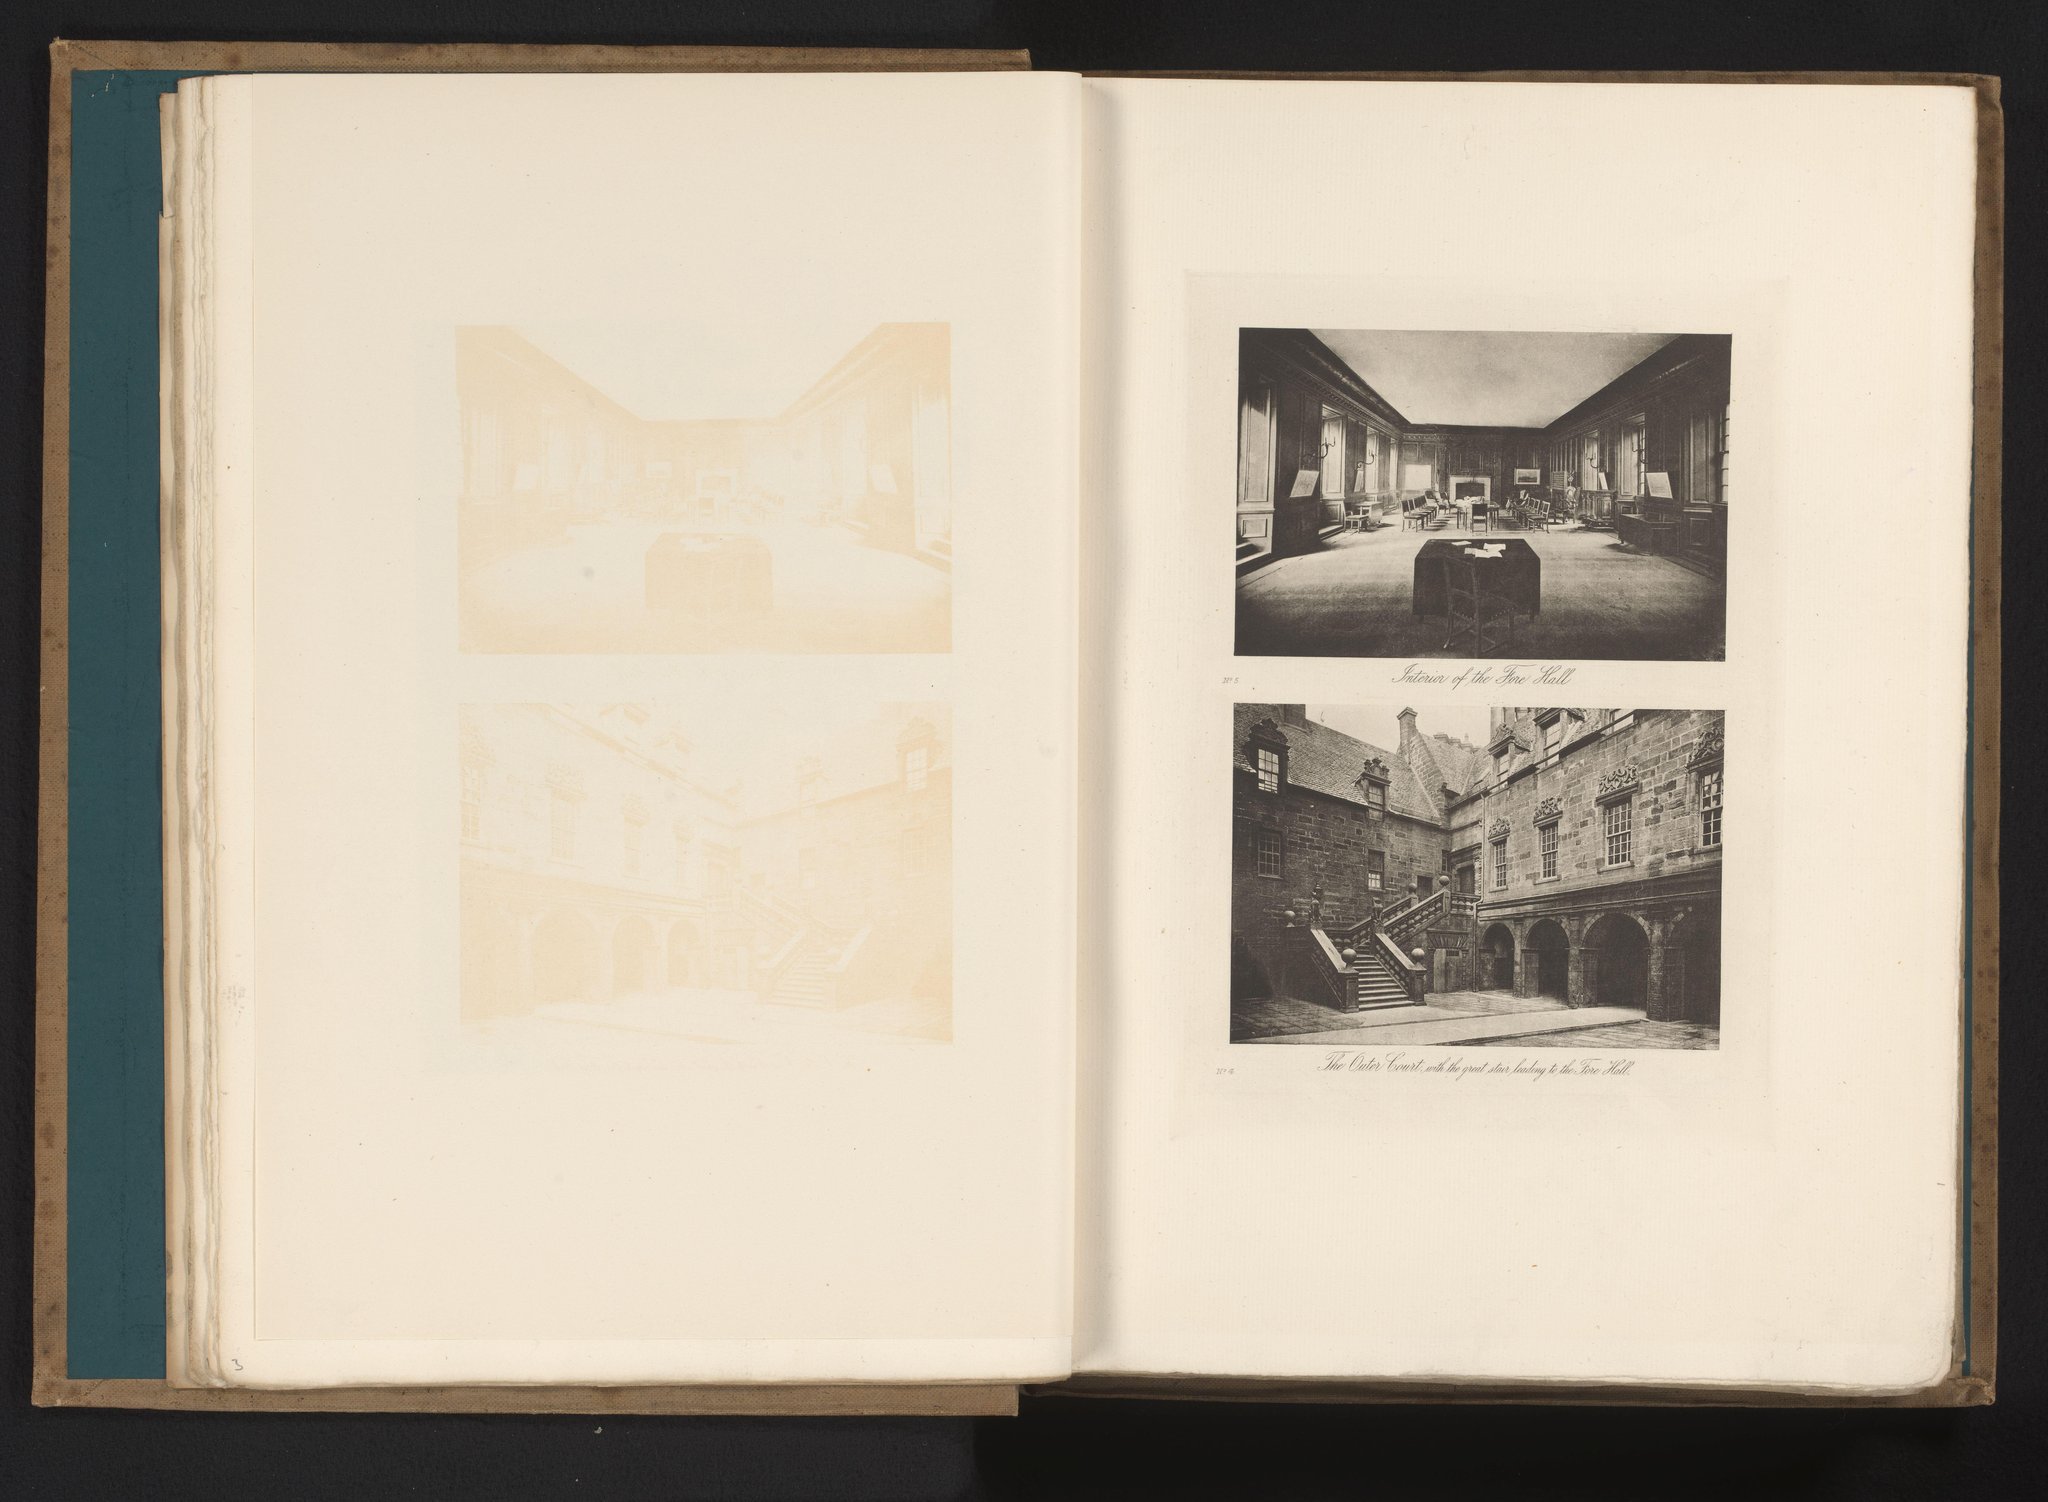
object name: page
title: Interior of the Fore Hall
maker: Anonymous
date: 1886-1891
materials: paper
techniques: photoaquatint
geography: glasgow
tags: university (+ building ~ education, tuition), courtyard, glasgow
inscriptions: inscription: ‘No.5/ No.4’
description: Prent op vijfde ongenummerde pagina na pagina iv.